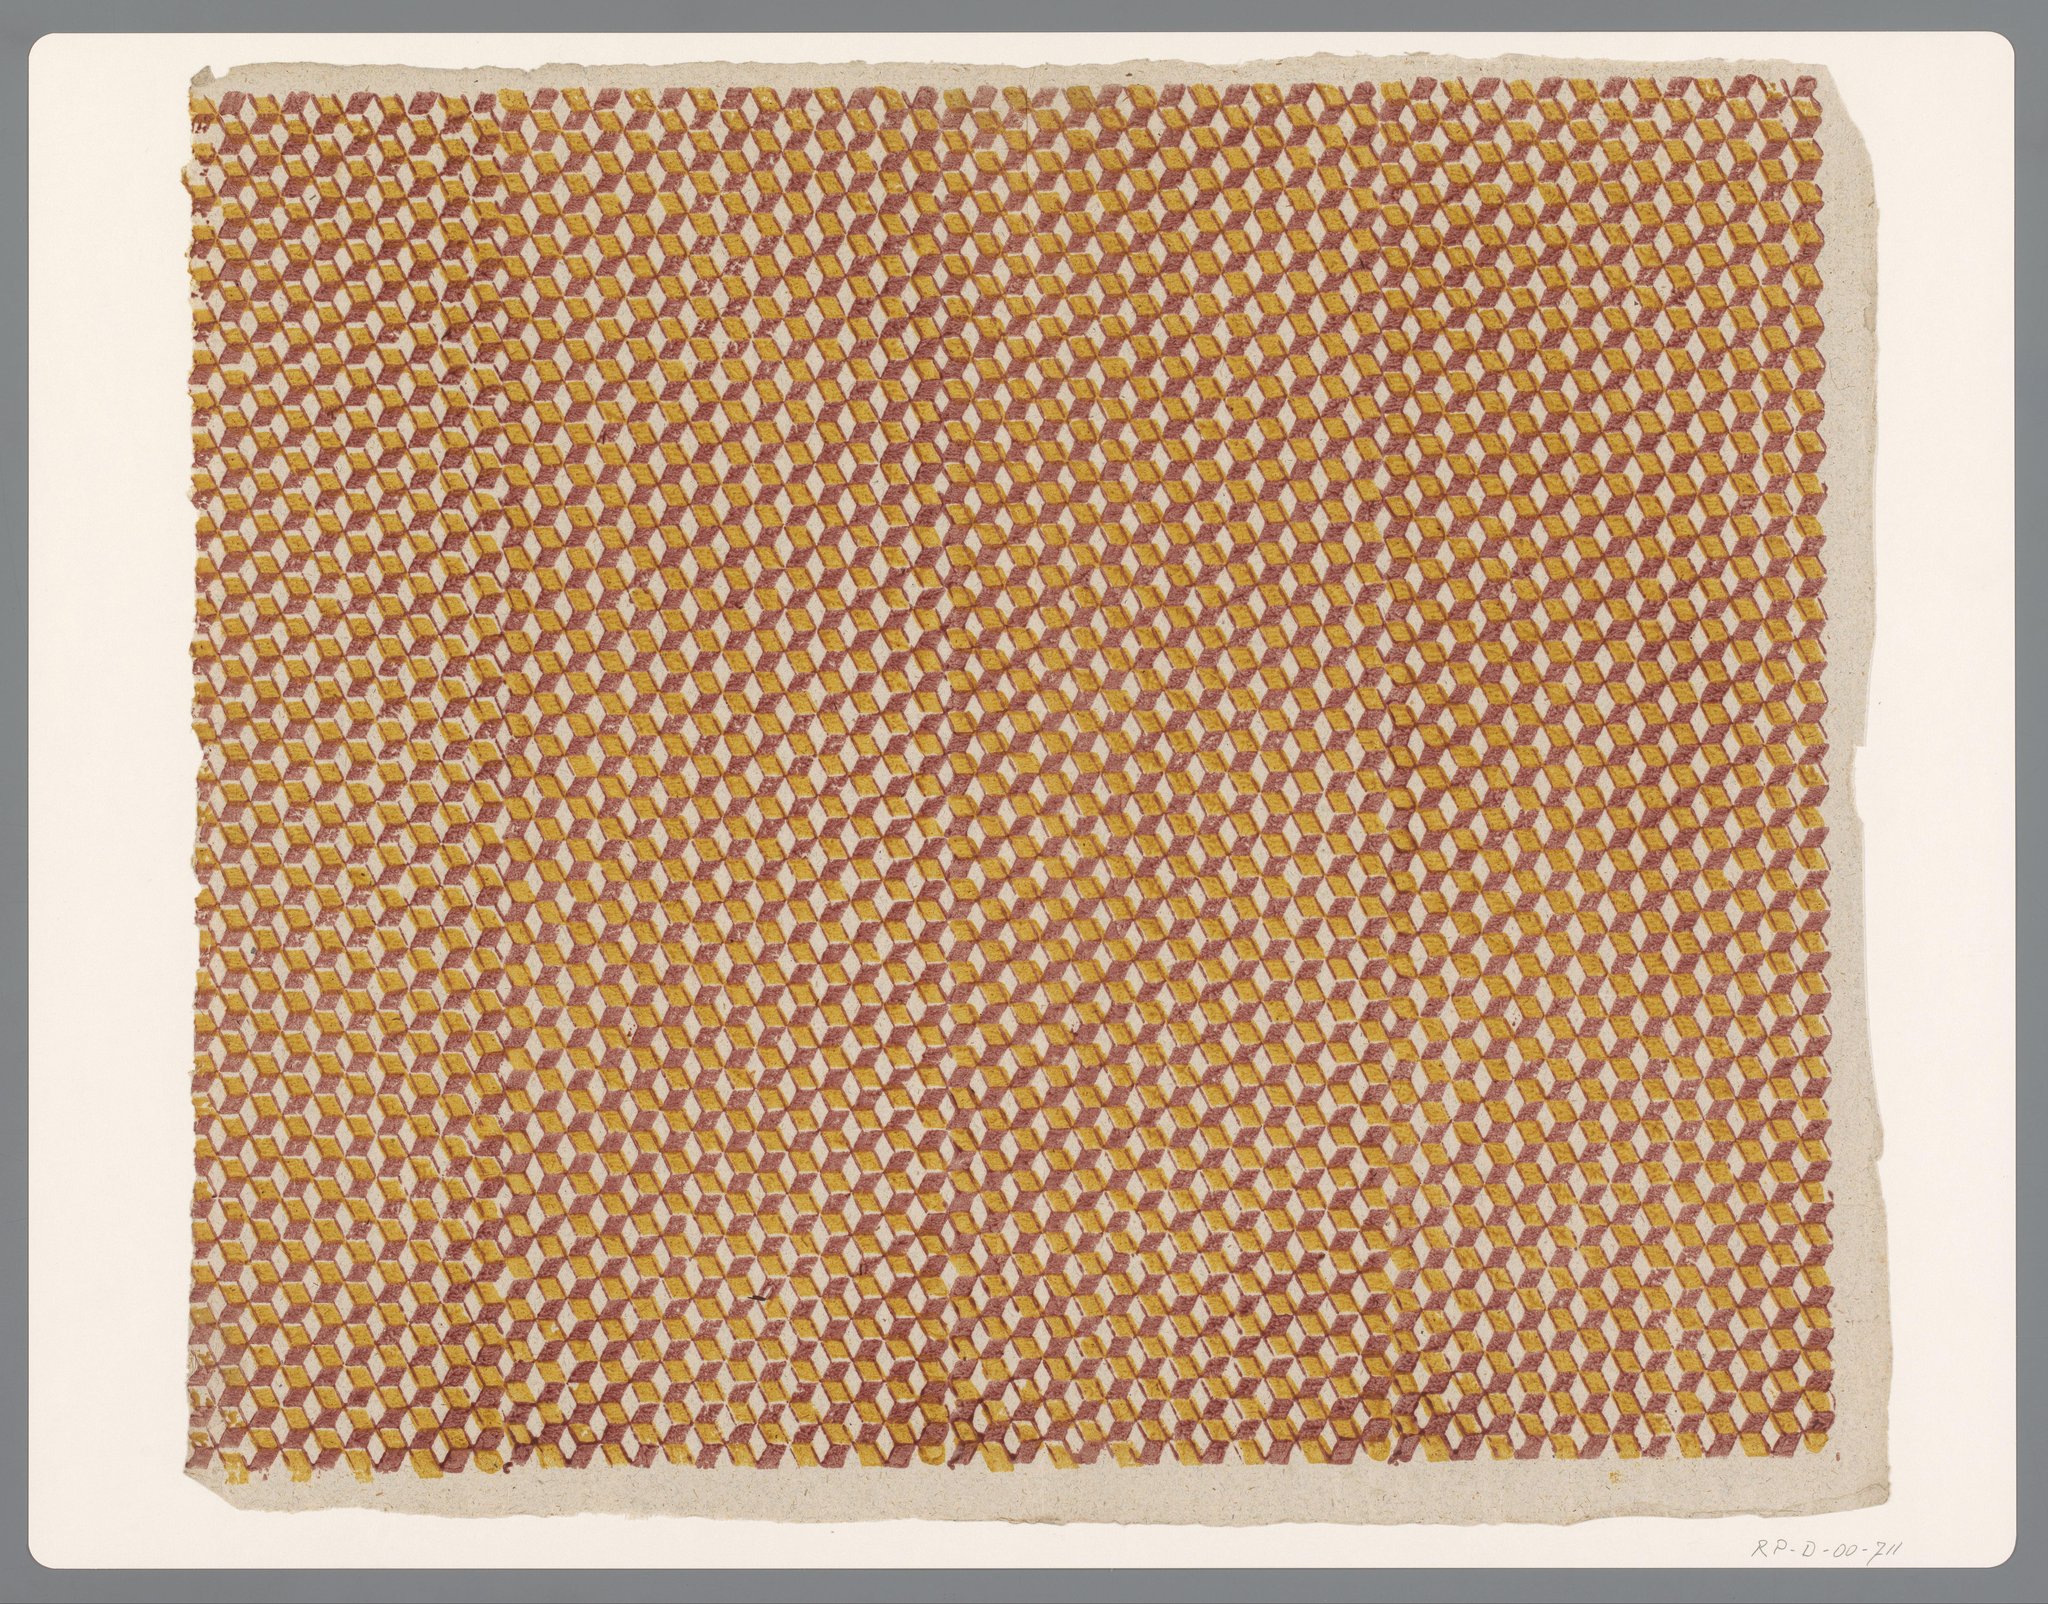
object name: printed paper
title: Blad met geometrisch patroon van blokken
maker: Anonymous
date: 1750-1900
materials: paper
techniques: printing block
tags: ornament ~ geometric motifs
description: Blad met geometrisch patroon van aaneengesloten blokken.